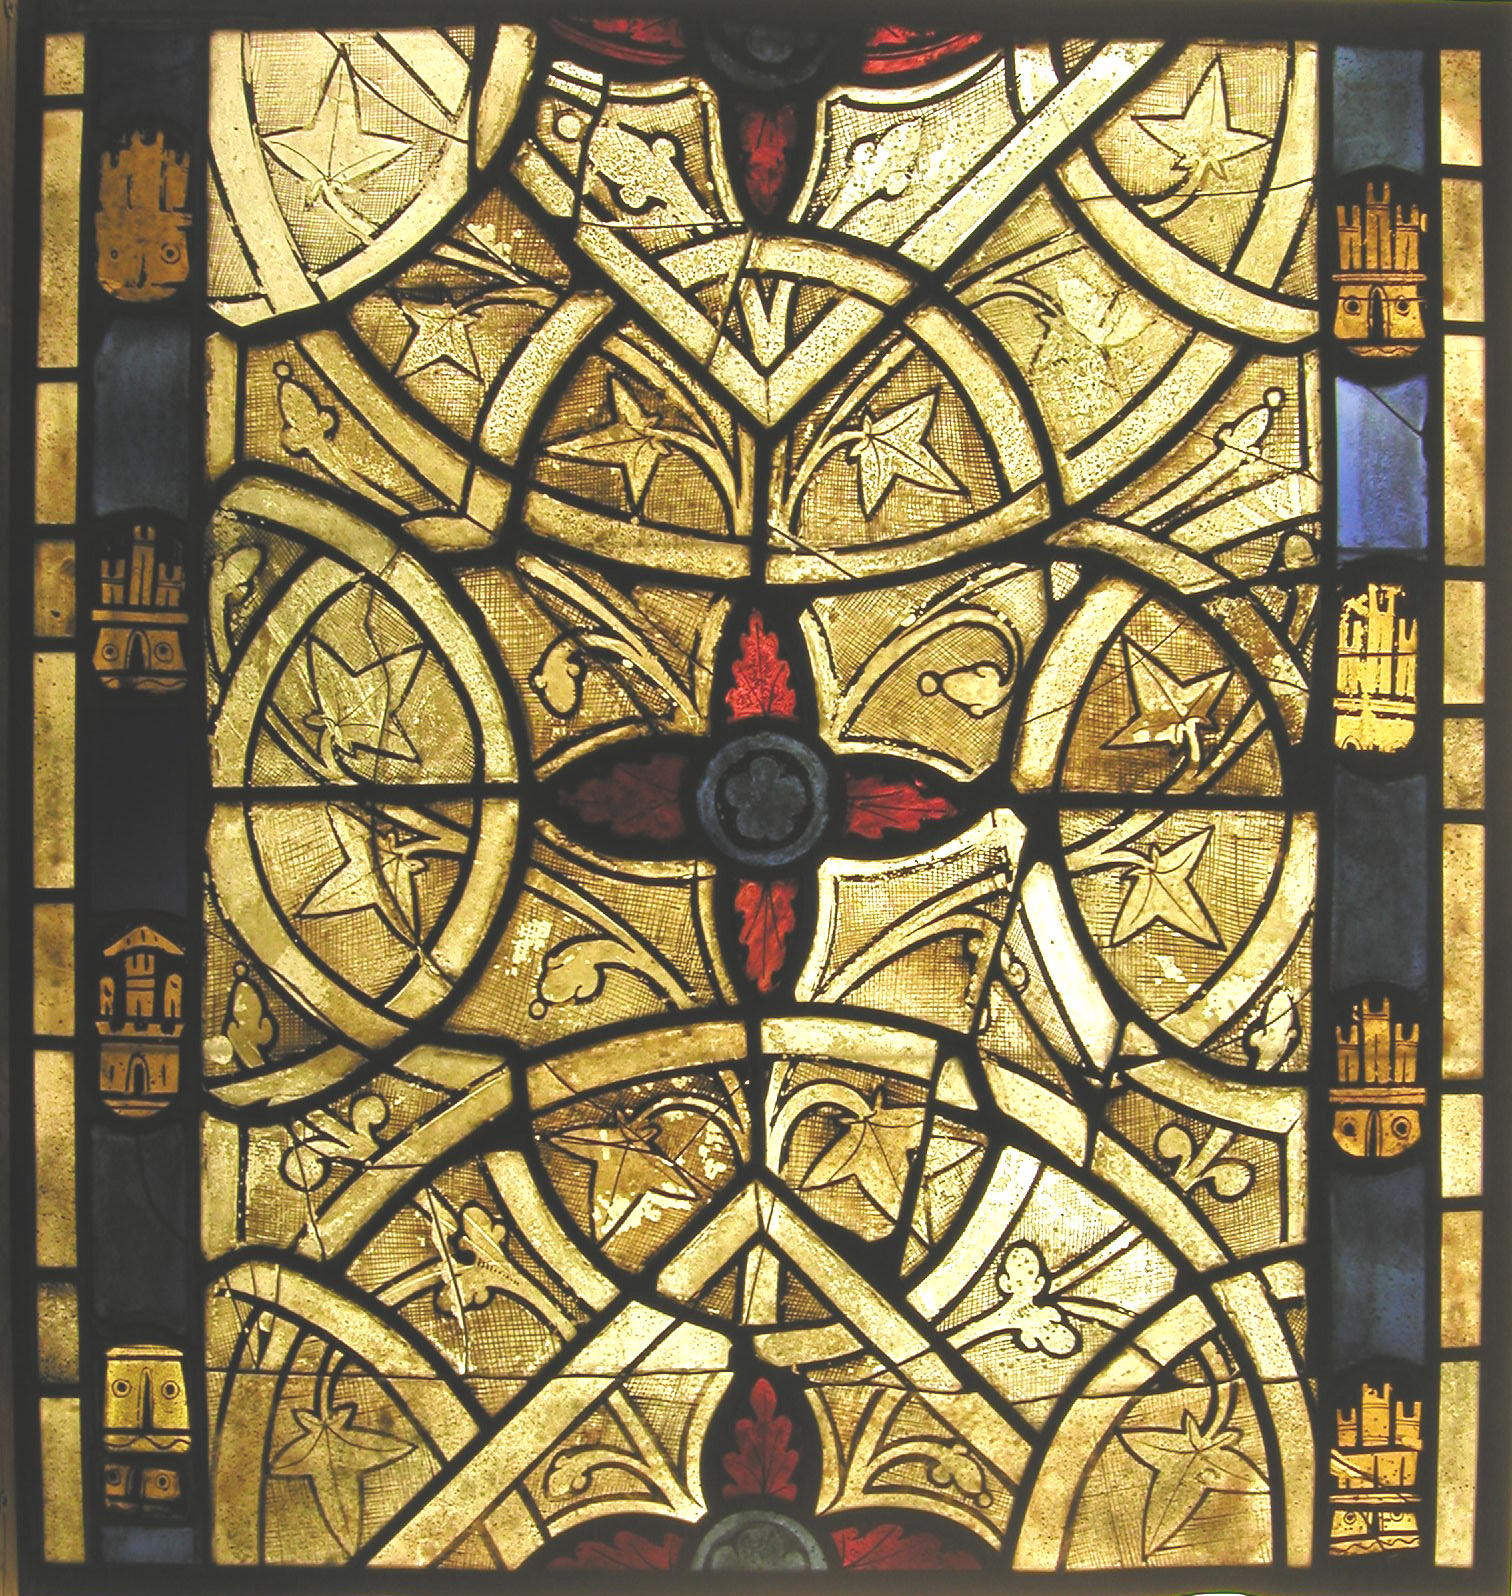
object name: panel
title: Grisaille Panel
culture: french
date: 1265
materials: glass, metal, paint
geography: france